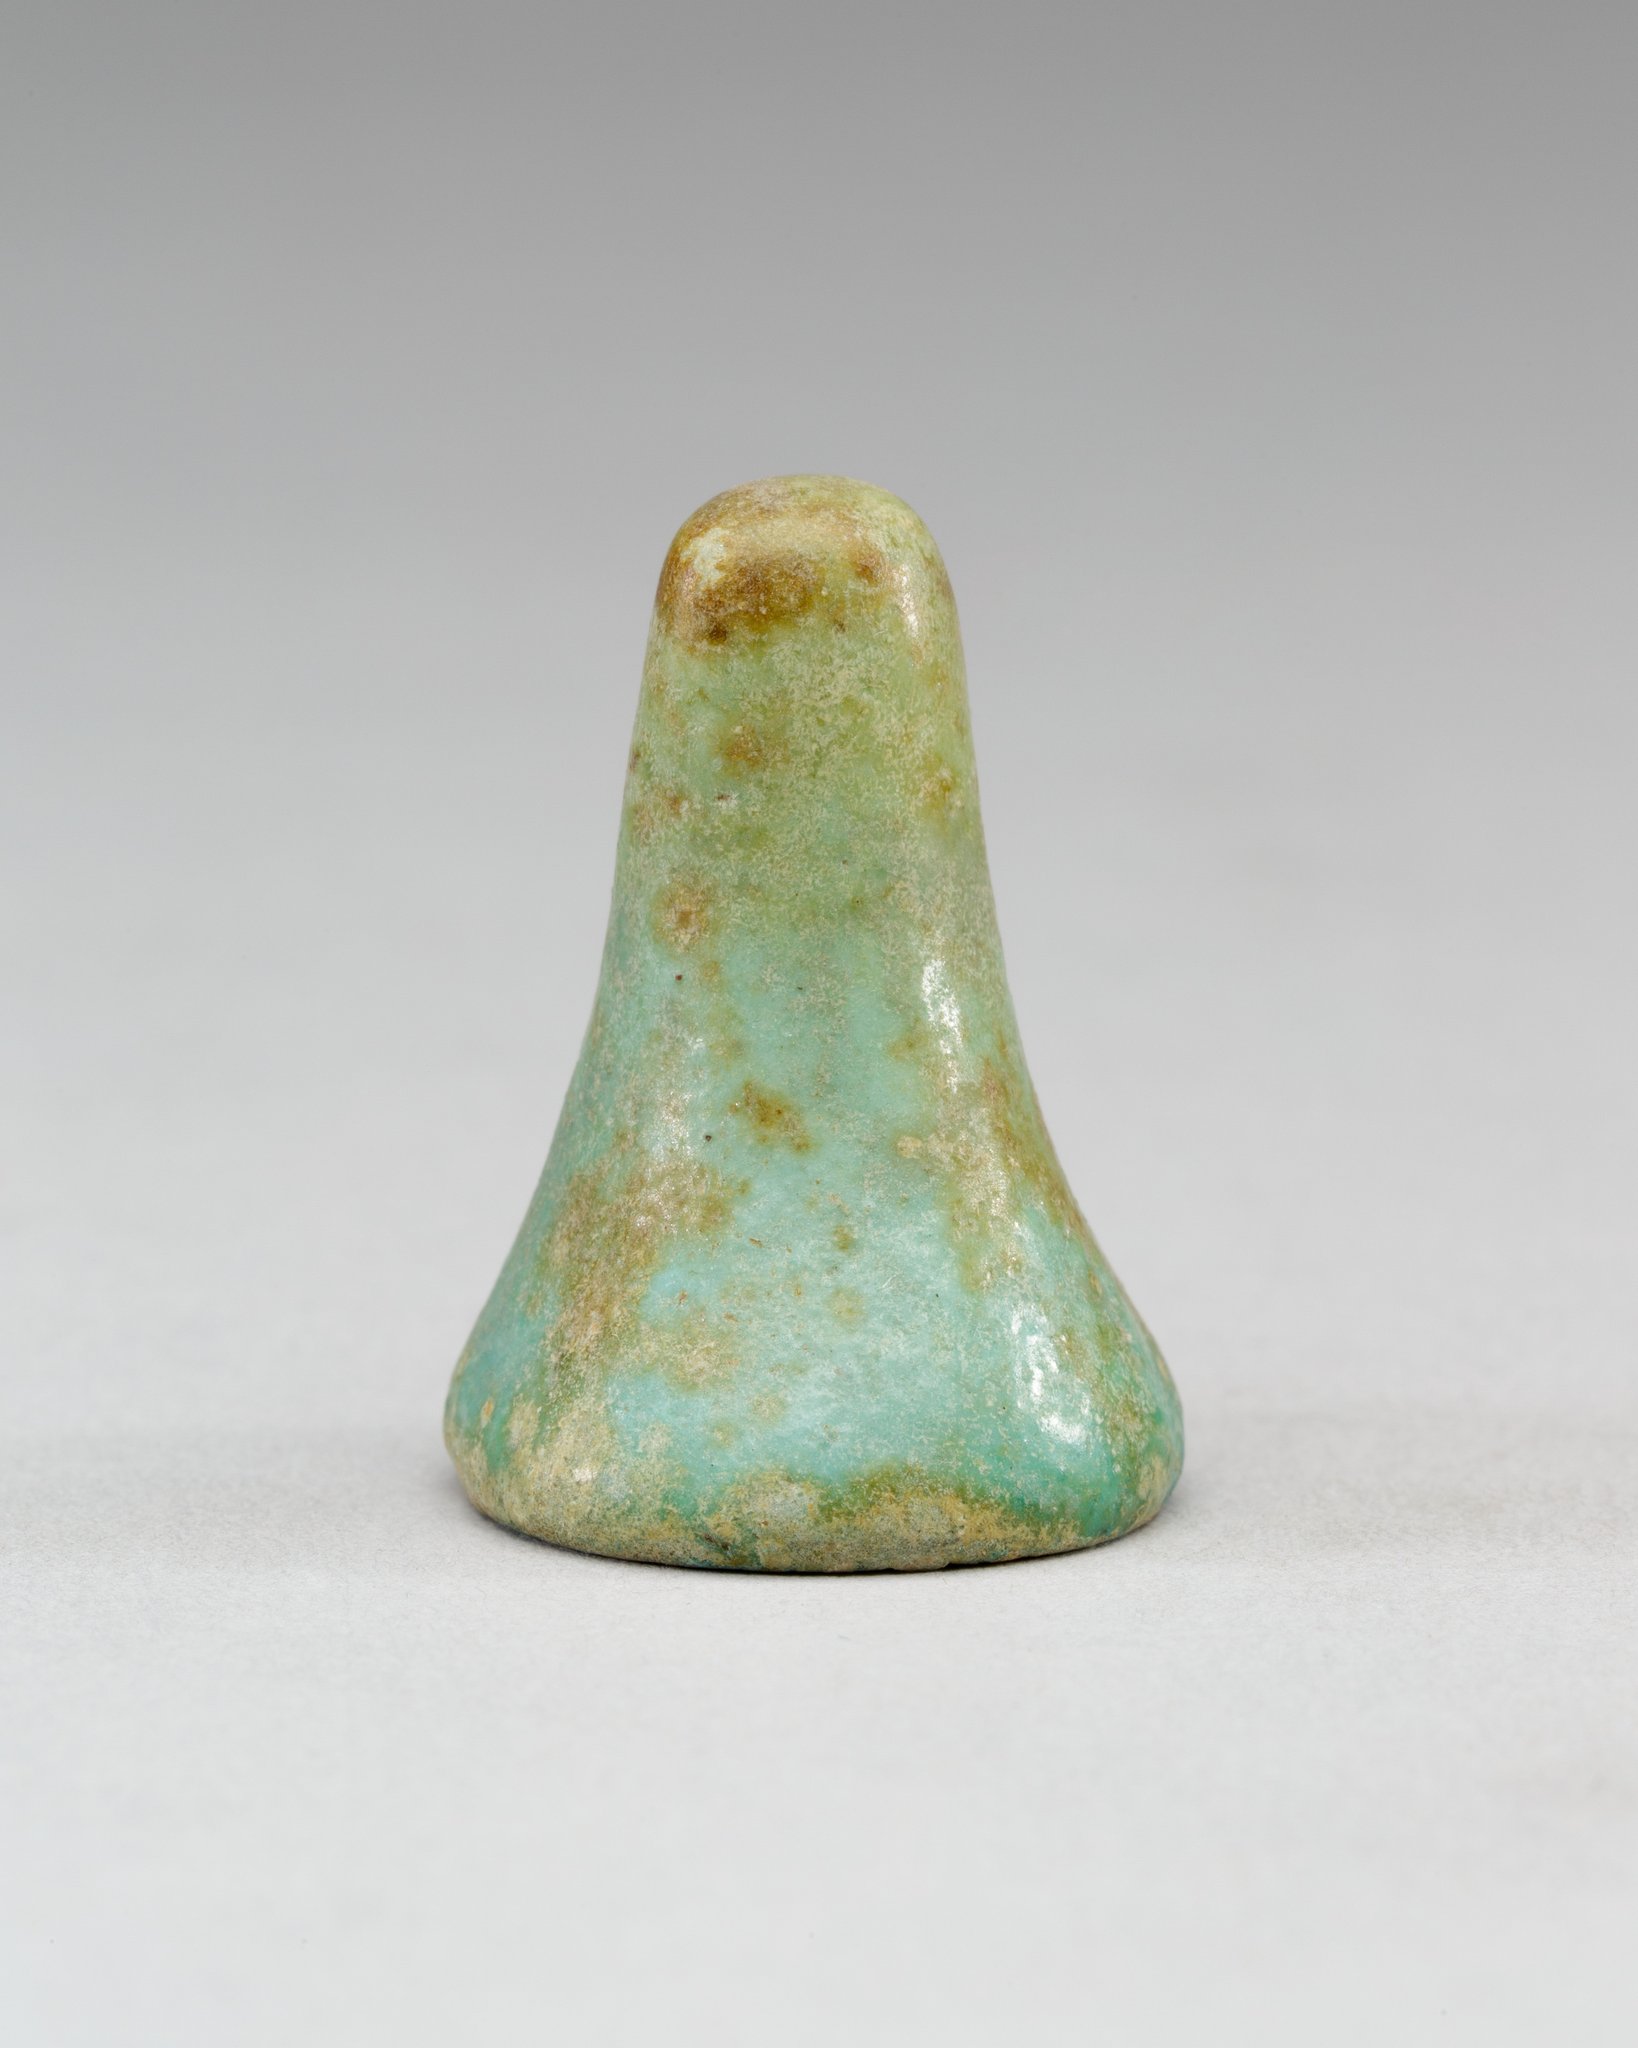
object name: game piece, conical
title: Conical Game Piece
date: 1504-1447 BCE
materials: faience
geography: egypt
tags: games